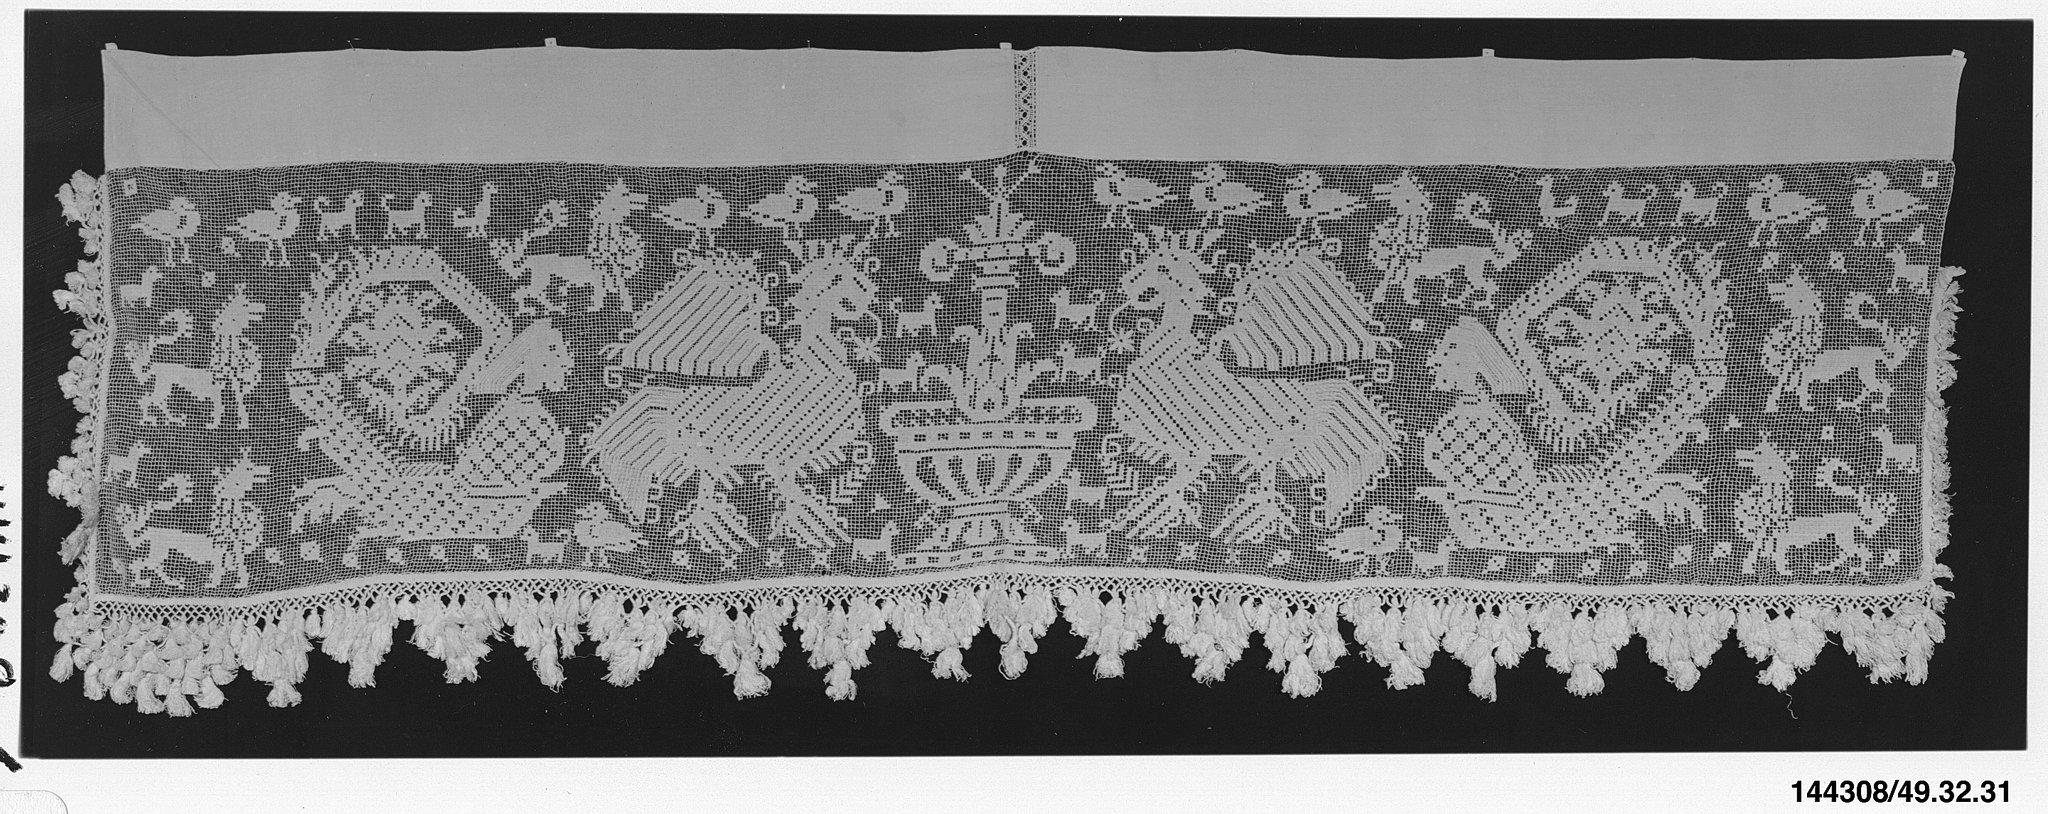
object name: altar frontal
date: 1601-1633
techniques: embroidery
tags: birds,griffins,lions